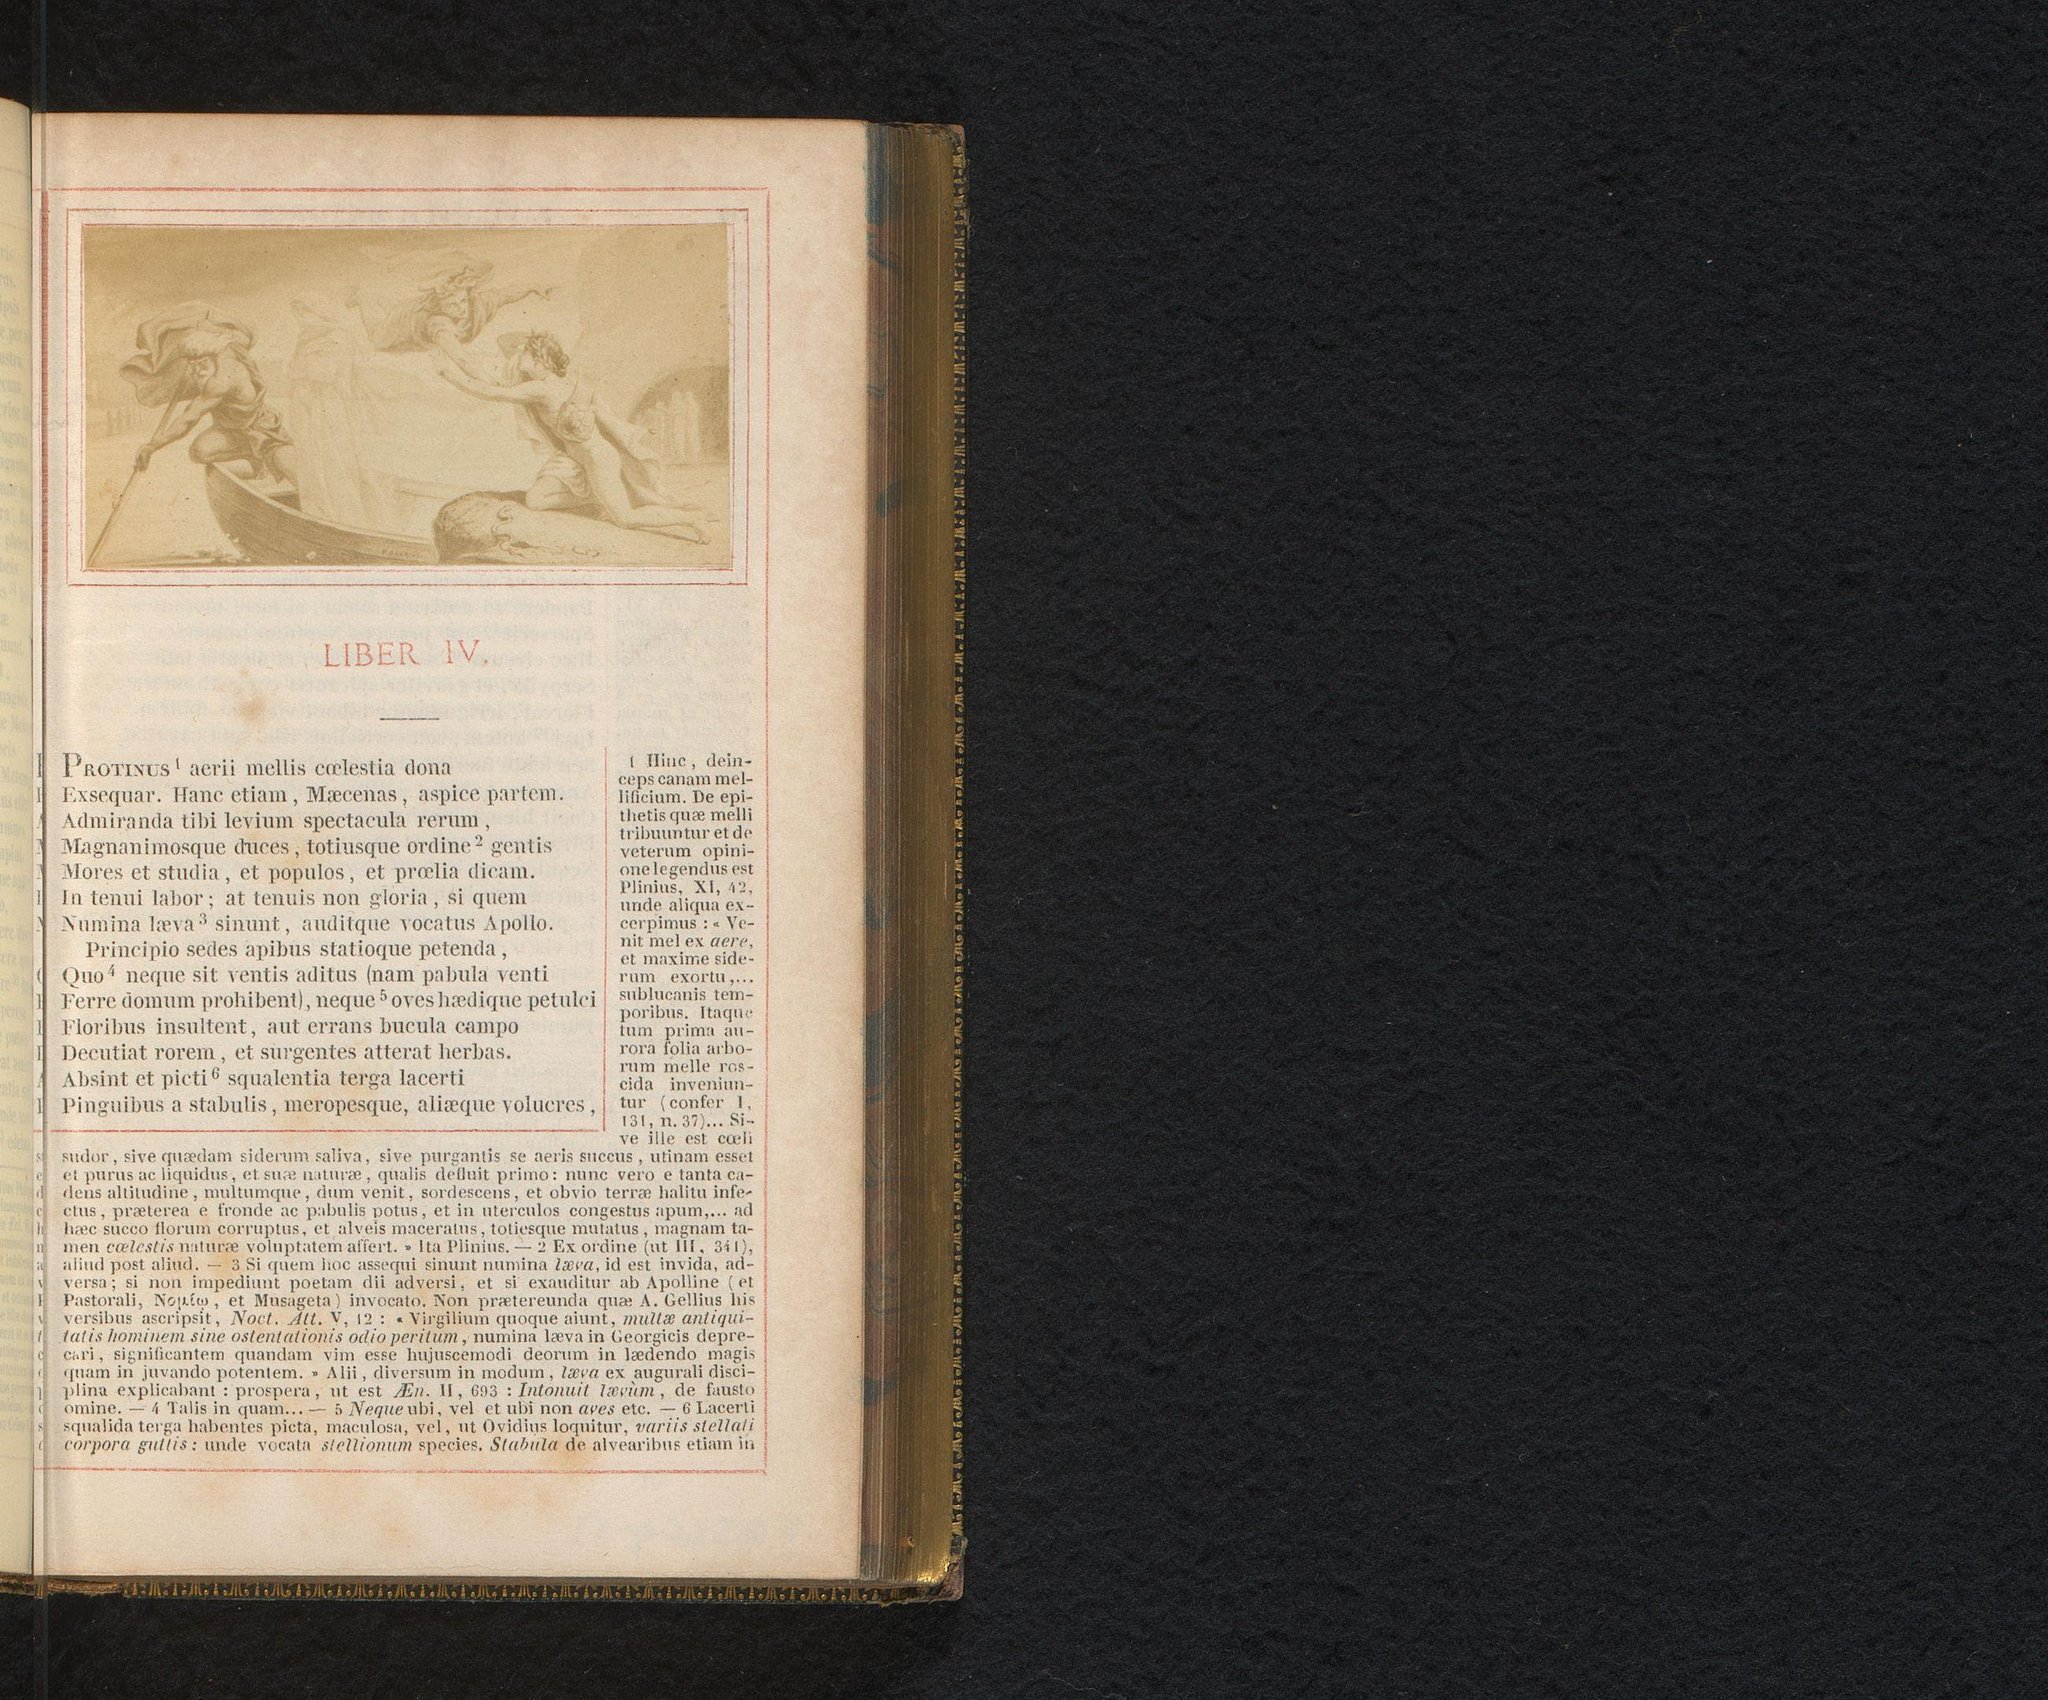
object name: photograph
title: Fotoreproductie van een schilderij, voorstellende de schim van Eurydice wordt de Styx overgeroeid en Orpheus blijft achter, scène uit Virgilius' Georgica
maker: Anonymous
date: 1853-1858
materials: paper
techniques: albumen print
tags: when leaving the underworld, orpheus looks back and loses eurydice for ever, charon, the ferryman